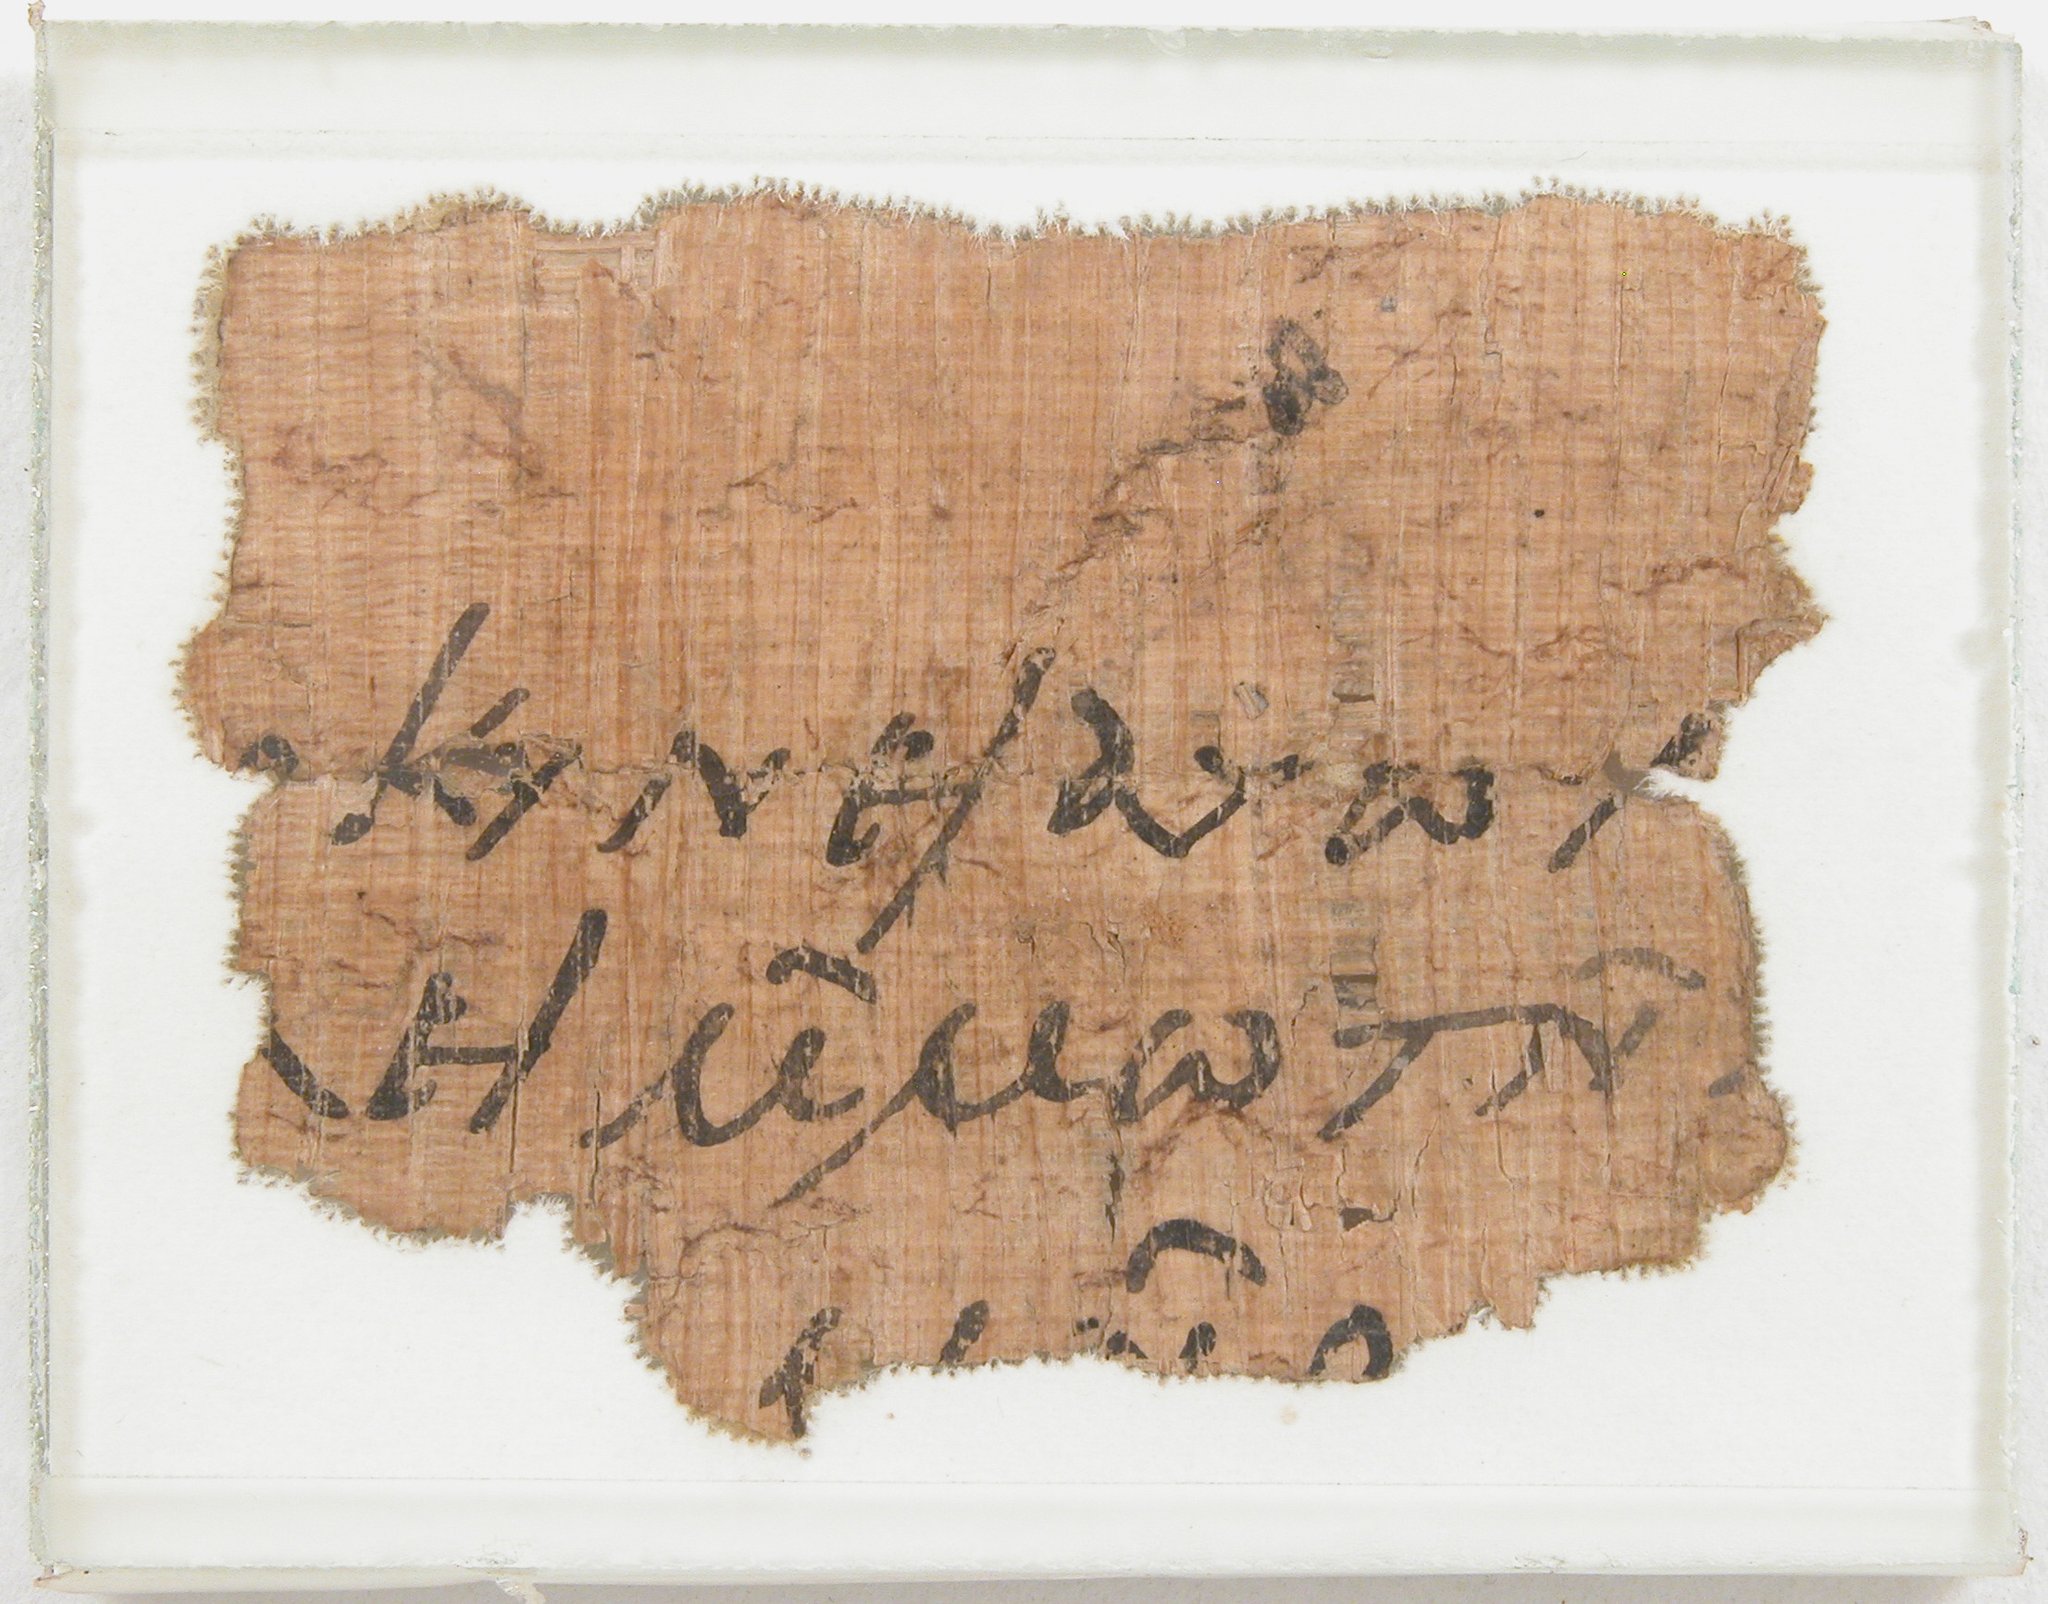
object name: fragment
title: Papyrus Fragments of a Letter to Epiphanius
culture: coptic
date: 601-700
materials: ink, papyrus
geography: egypt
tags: coptic,documents